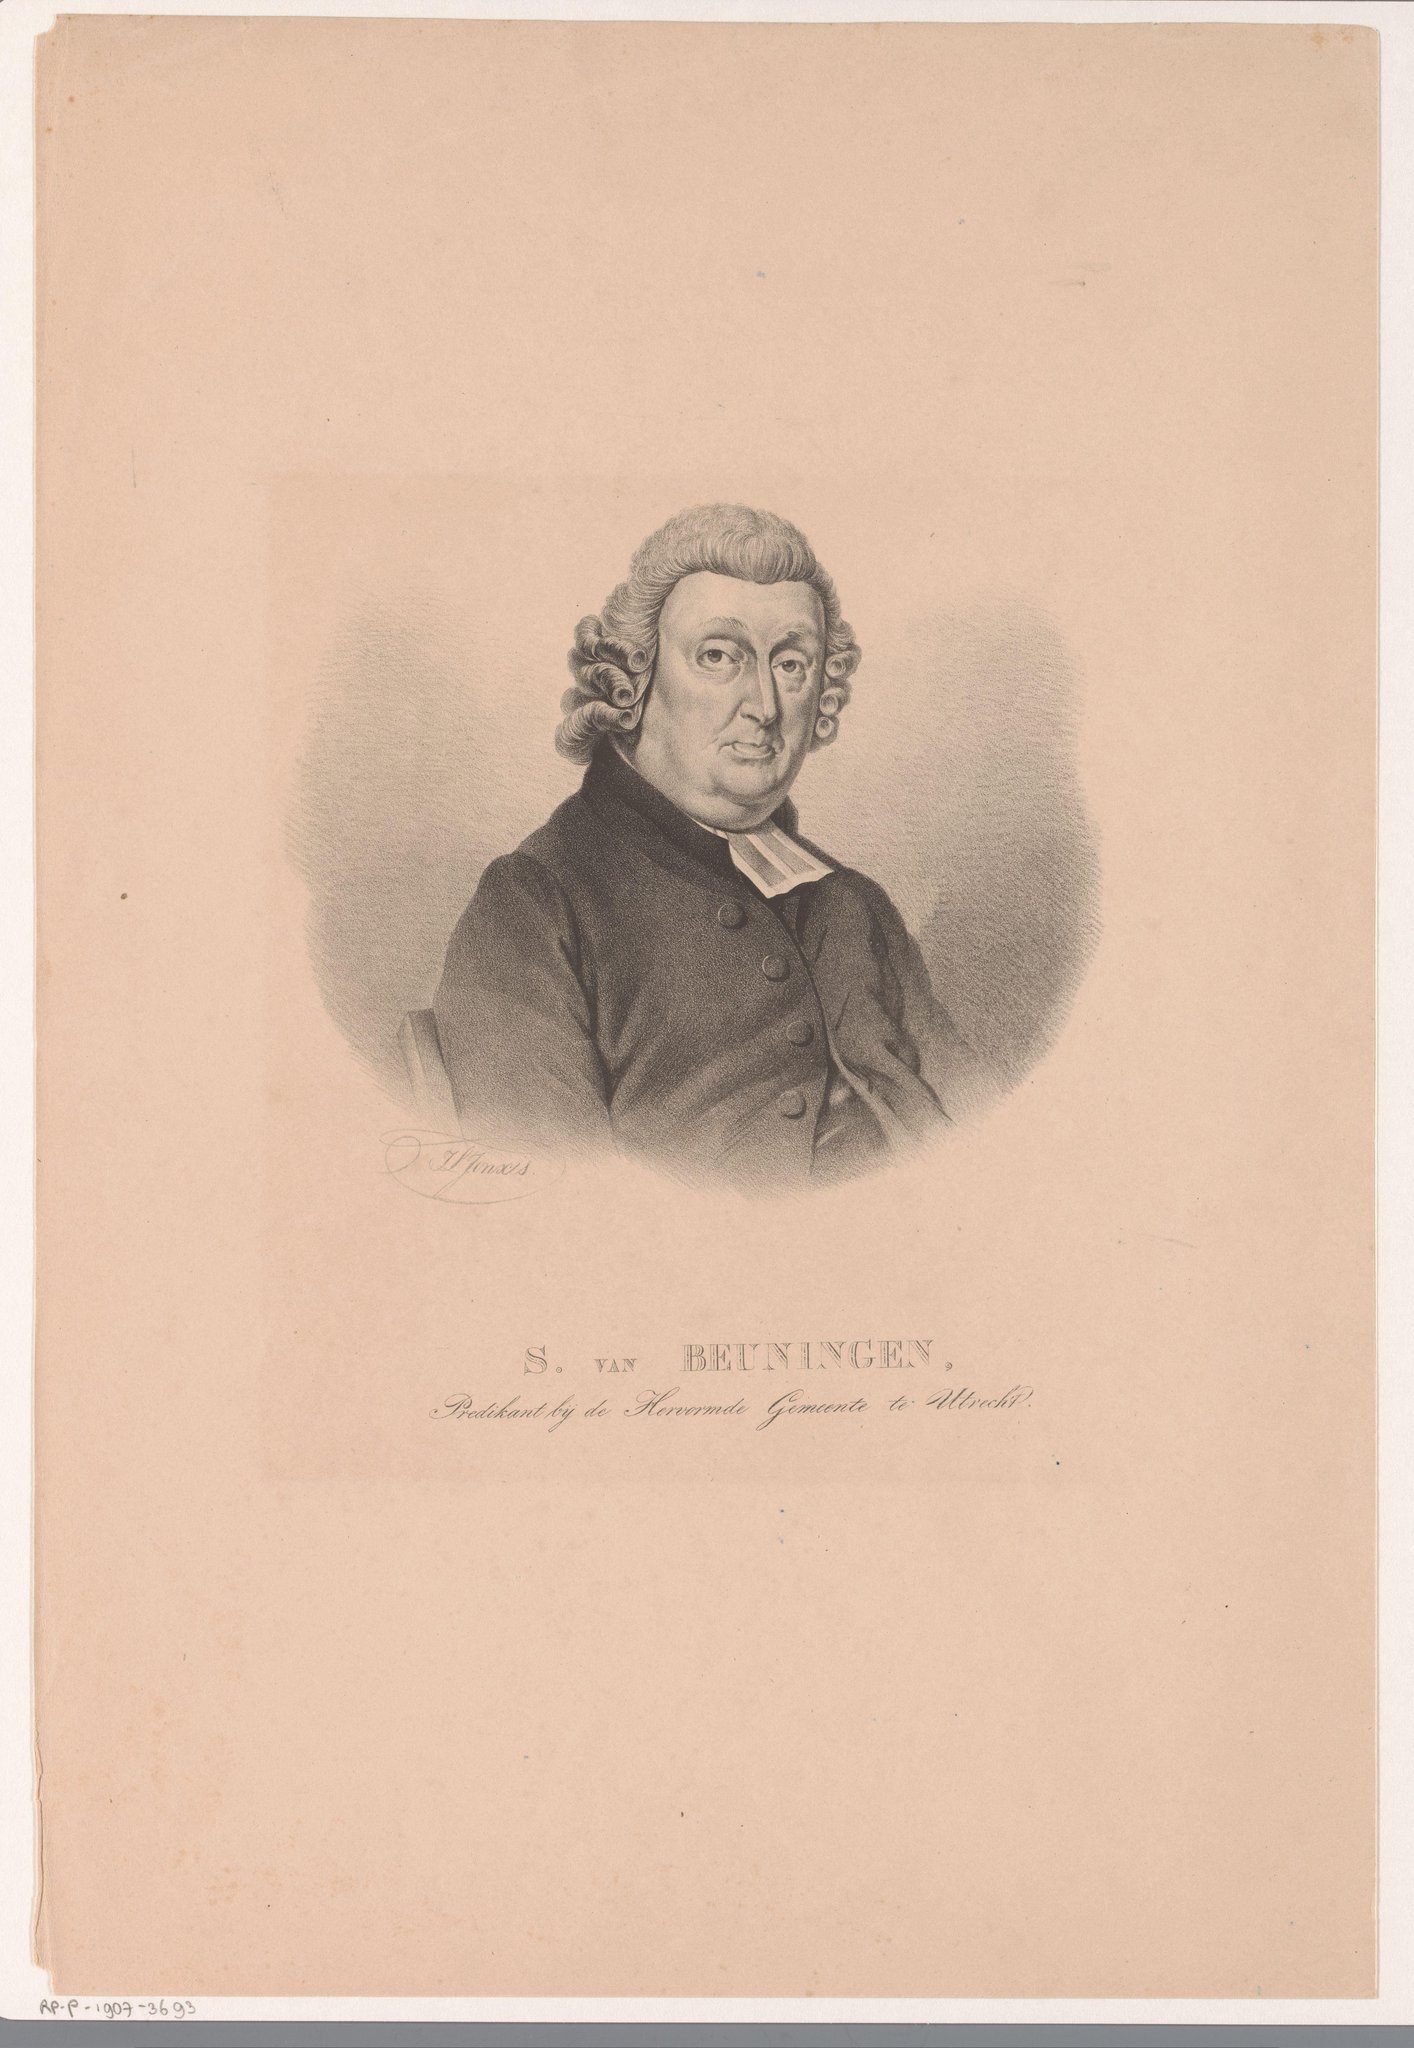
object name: print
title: Portret van Samuel van Beuningen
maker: jan lodewijk jonxis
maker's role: draughtsman, painter, print maker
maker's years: 1789-1867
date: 1809-1867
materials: paper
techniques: lithograph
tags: historical persons (+ (full) bust portrait)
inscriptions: collector's mark: Lugt 2228